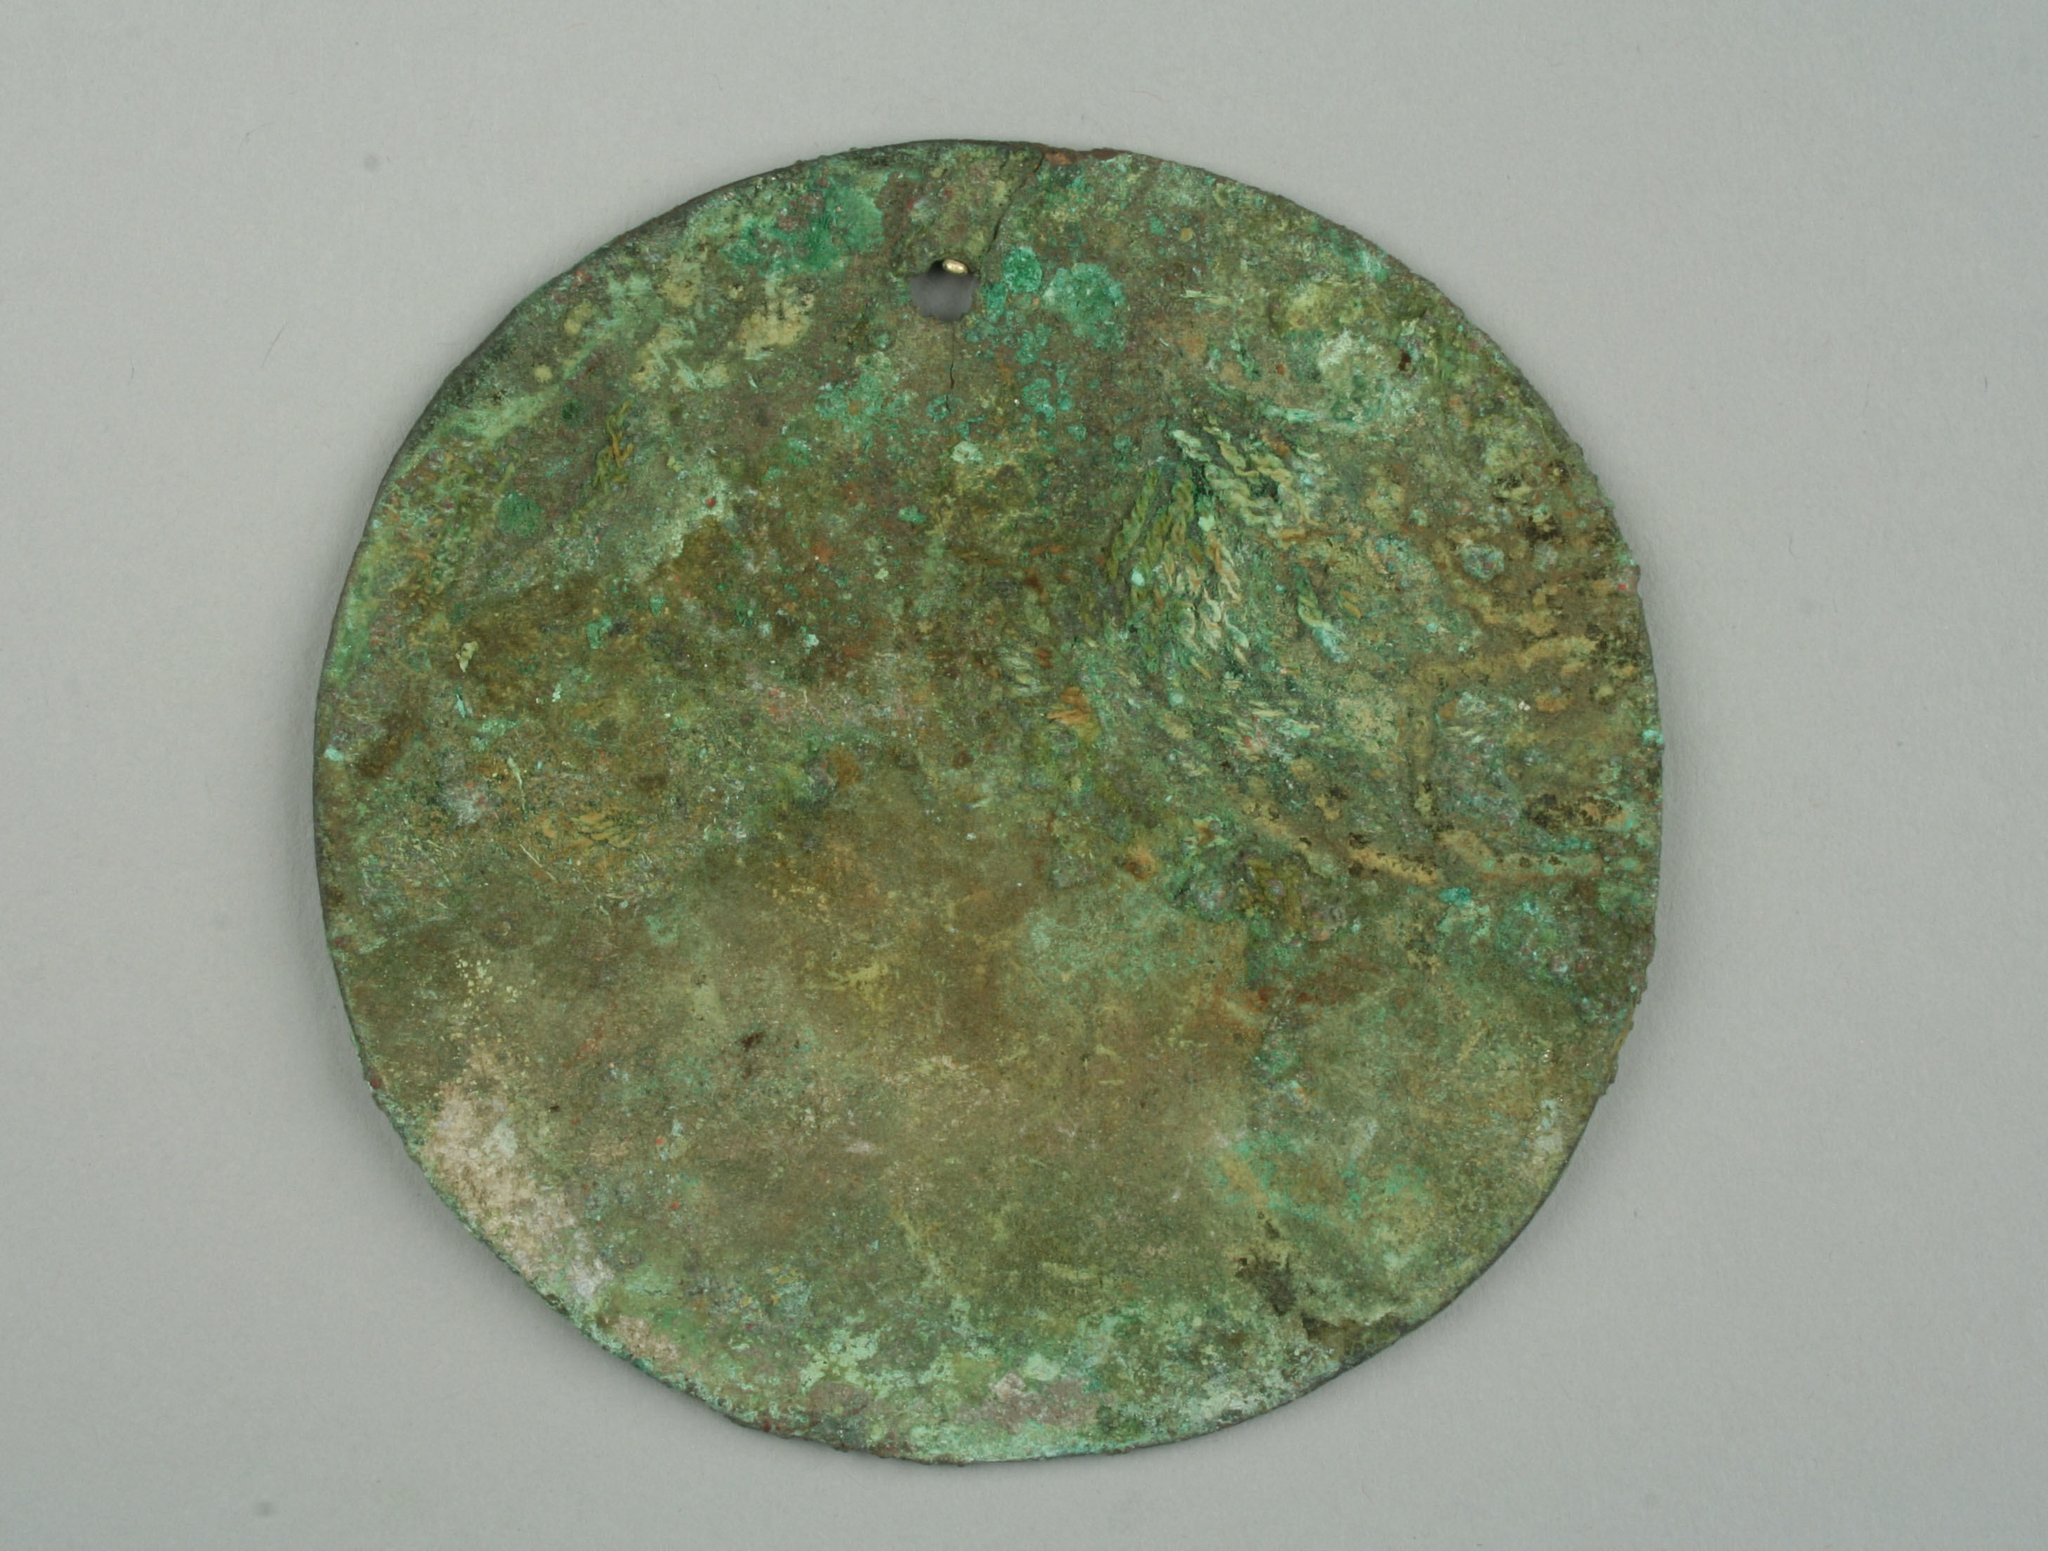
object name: plaque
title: Round Plaque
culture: vicús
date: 300 BCE-200 CE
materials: copper, gilt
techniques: hammering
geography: peru